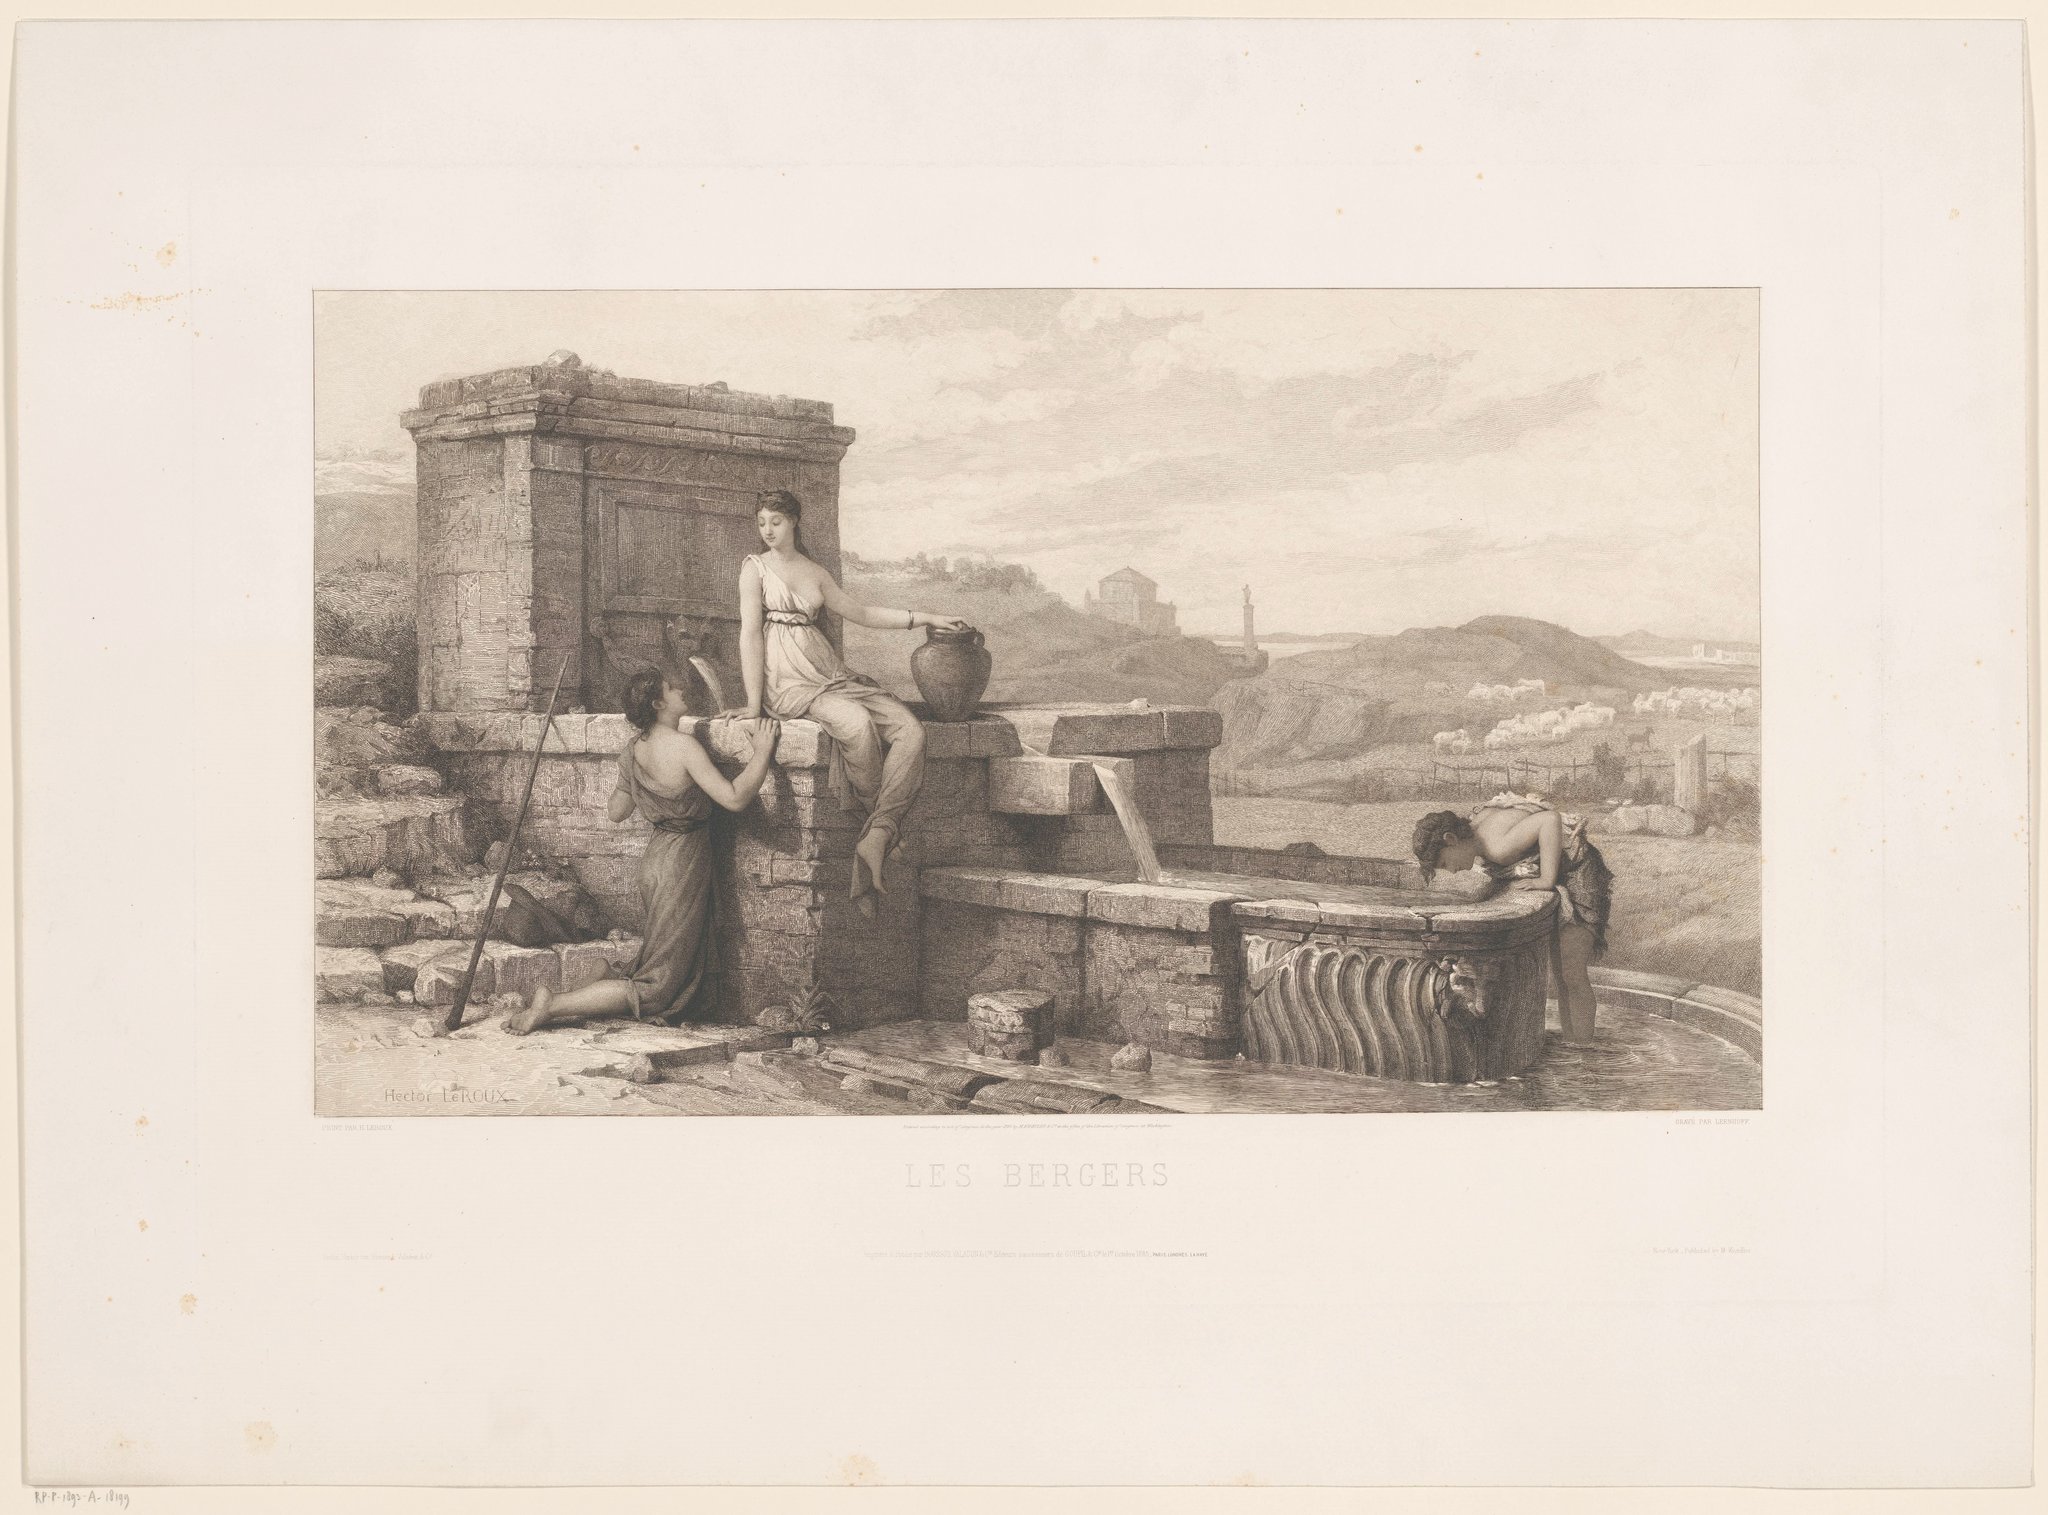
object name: print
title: Les bergers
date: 1885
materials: paper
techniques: engraving, etching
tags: herding, herdsman, herdswoman, shepherd, shepherdess, cowherd, etc., ornamental fountain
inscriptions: collector's mark: Lugt 2228